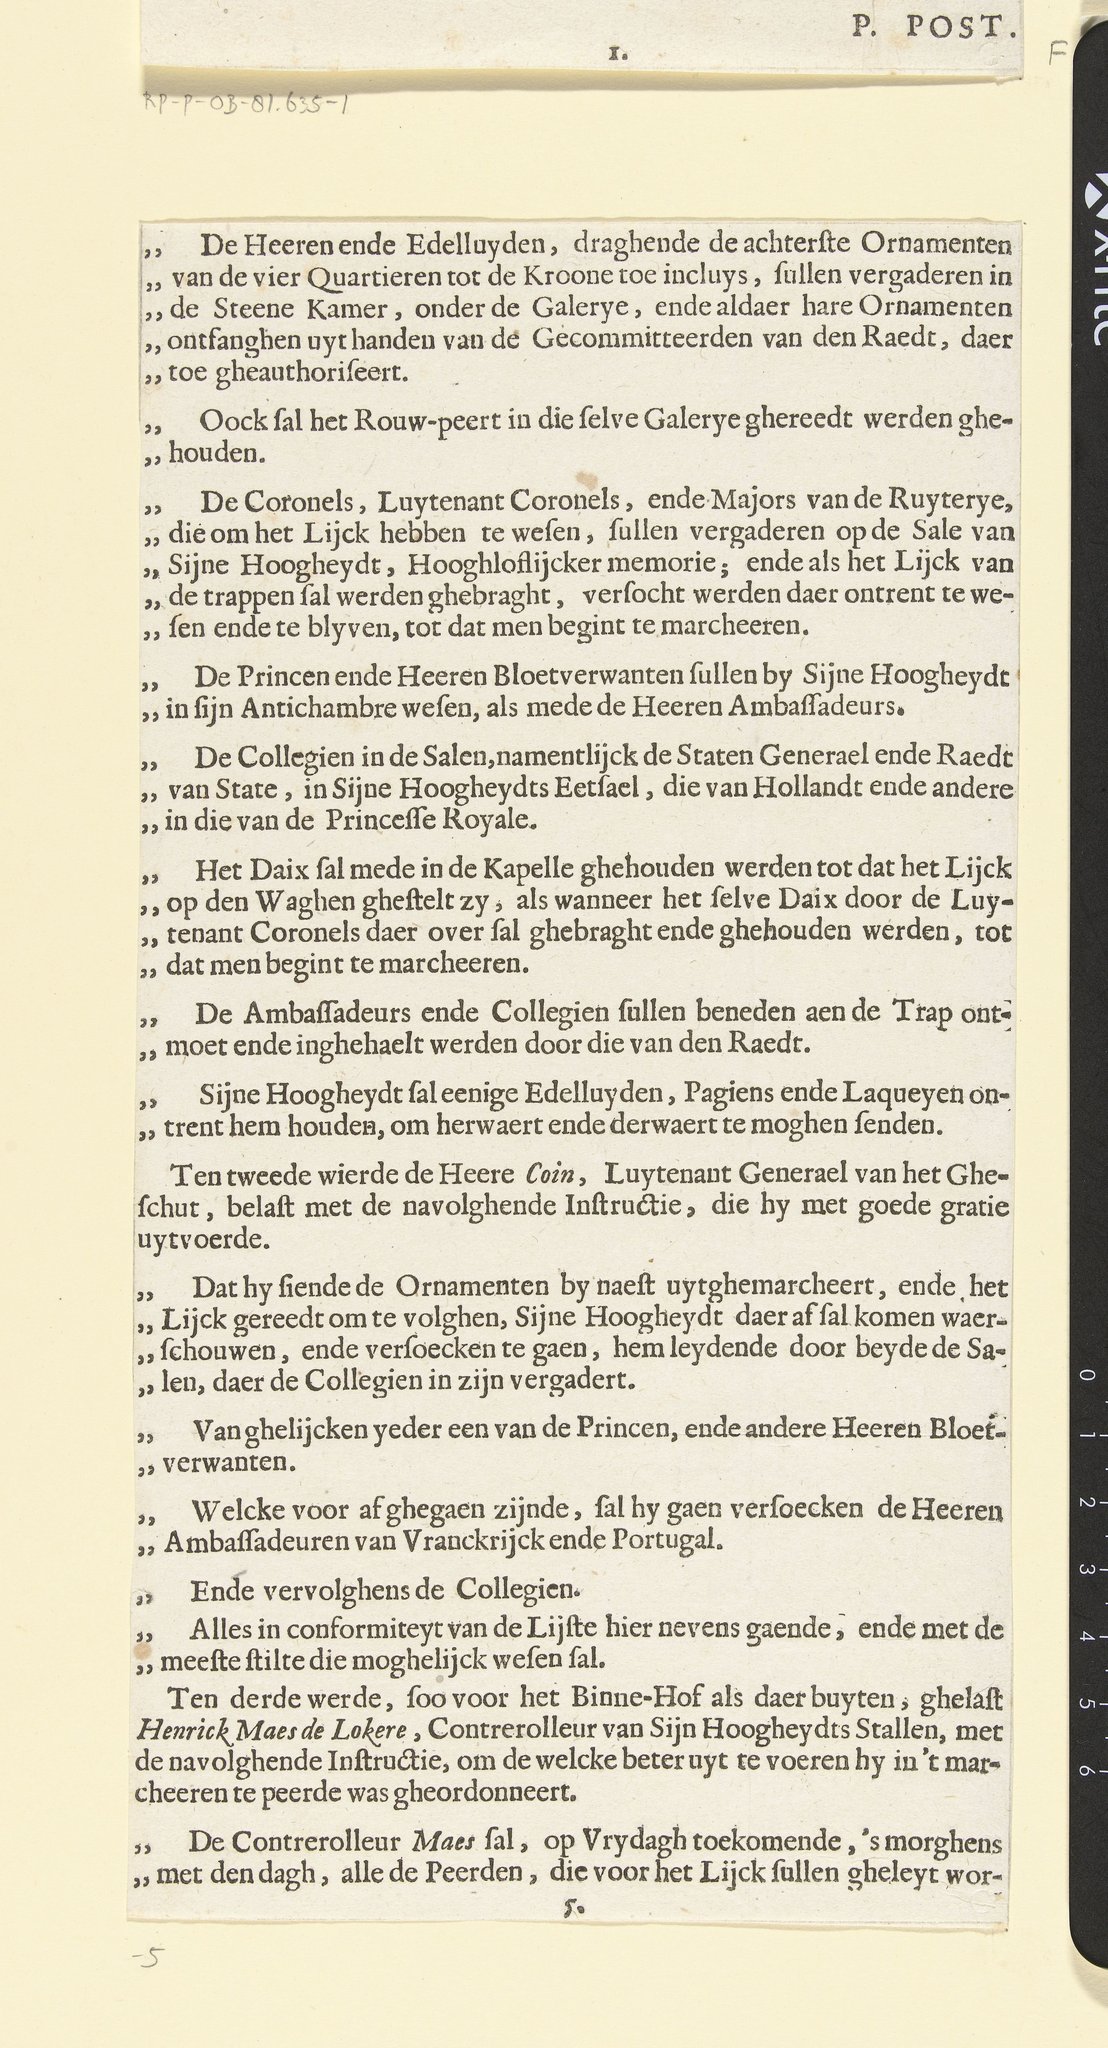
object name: text sheet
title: De begrafenisstoet van stadhouder Frederik Hendrik te 's-Gravenhage in 1647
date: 1651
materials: paper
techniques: letterpress printing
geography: amsterdam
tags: the hague, frederick henry (prince of orange)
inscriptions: collector's mark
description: Tekstblad nr. 5 bij de prentserie van de begrafenisstoet van stadhouder Frederik Hendrik te 's-Gravenhage op 10 mei 1647. Onderdeel van een serie van 30 platen en 20 tekstbladen, bedoeld om aan elkaar geplakt te worden.